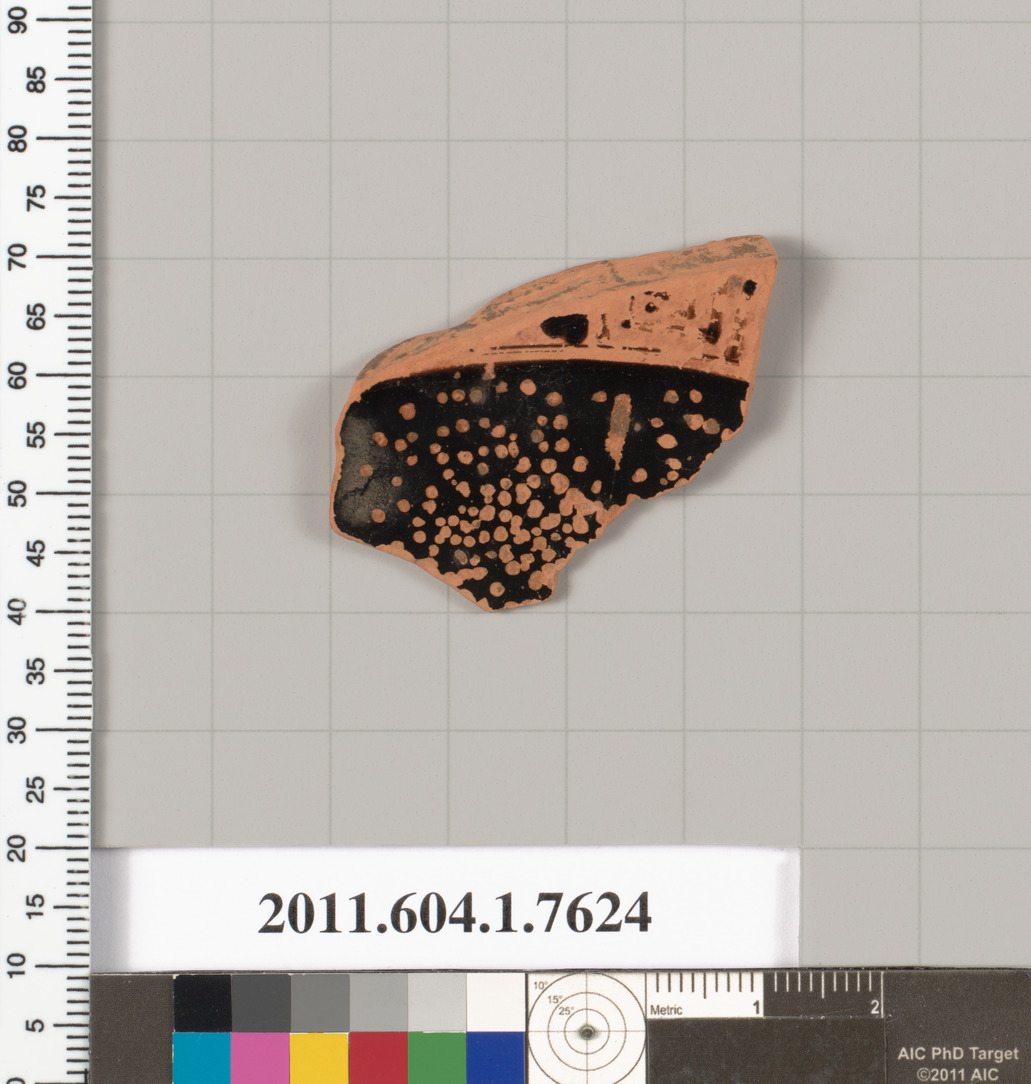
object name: kylix fragment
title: Terracotta fragment of a kylix (drinking cup)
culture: greek, attic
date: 460-450 BCE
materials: terracotta